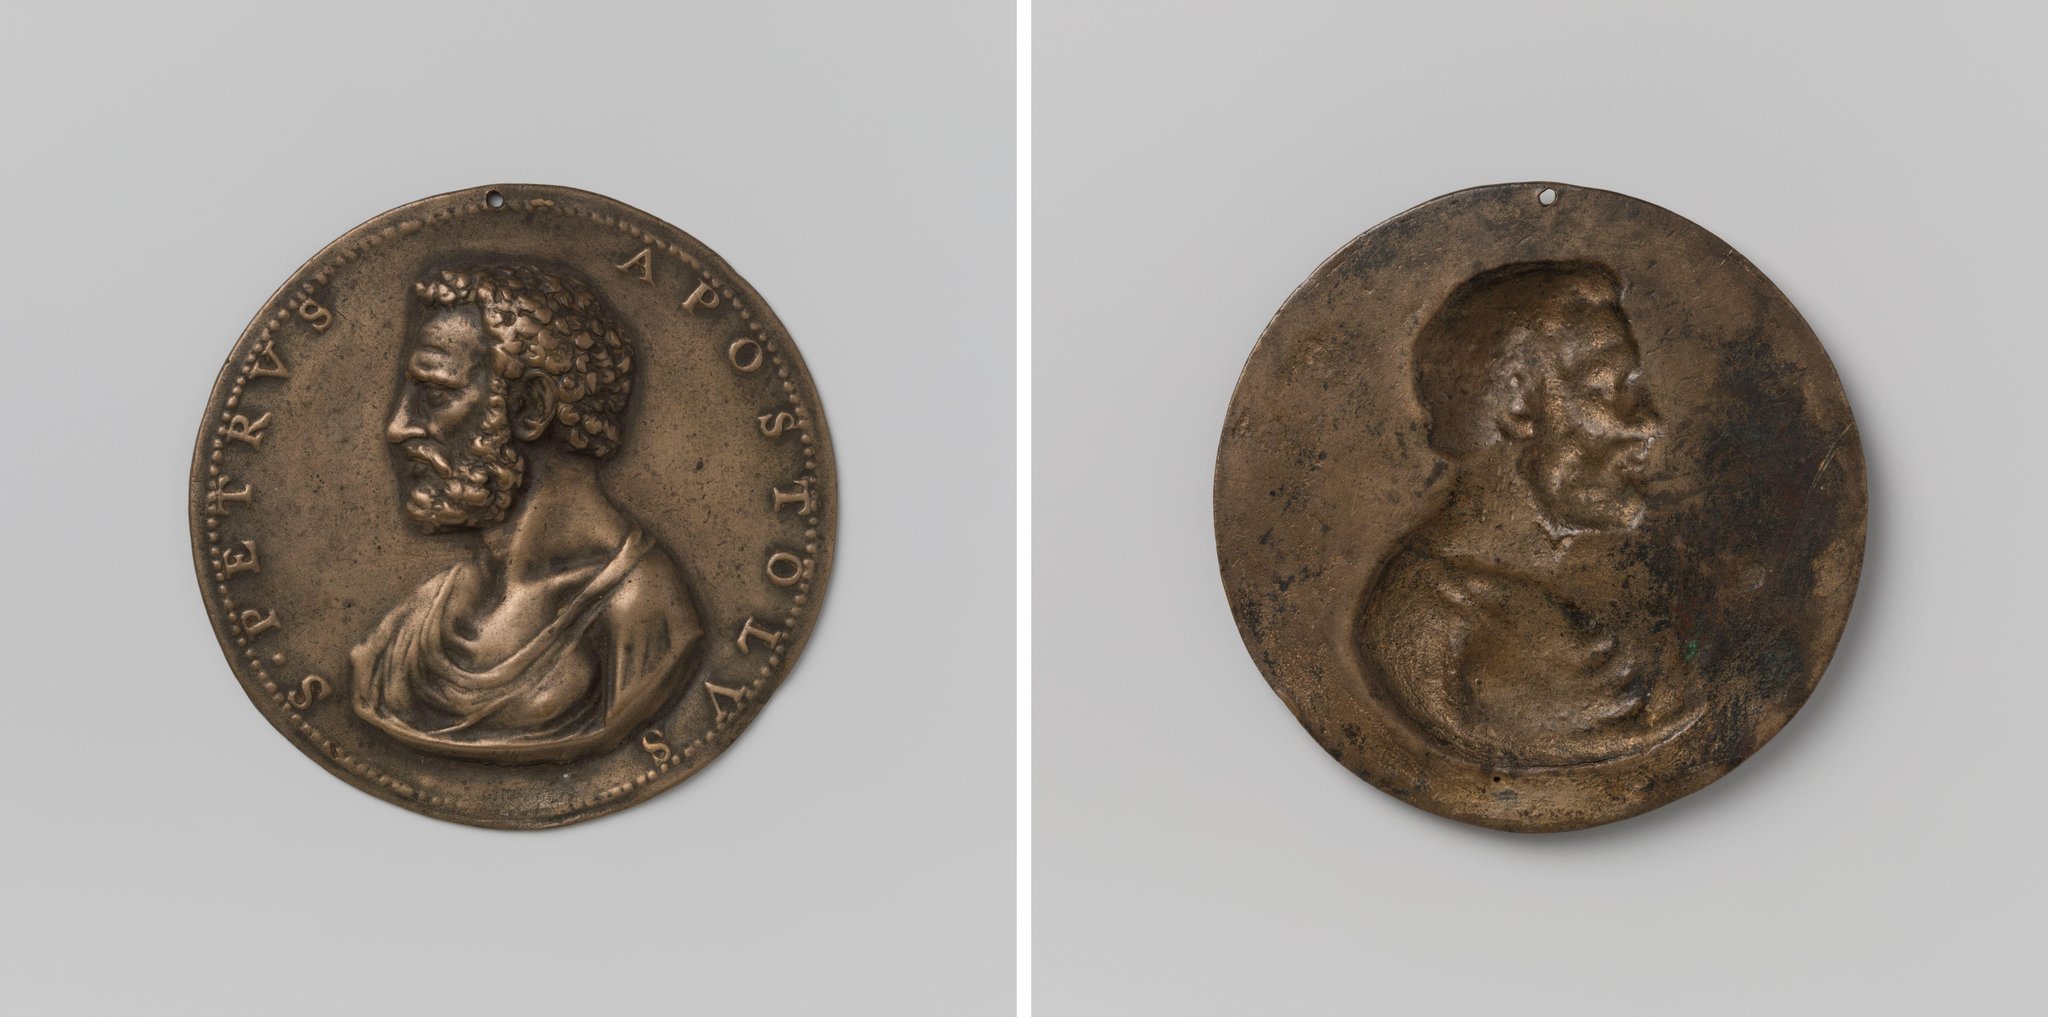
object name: copy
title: Heilige Petrus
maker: Anonymous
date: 1550-1750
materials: copper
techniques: striking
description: eenzijdige plaquette met gat erin. Voorzijde: borststuk man binnen omschrift. Keerzijde: blanco